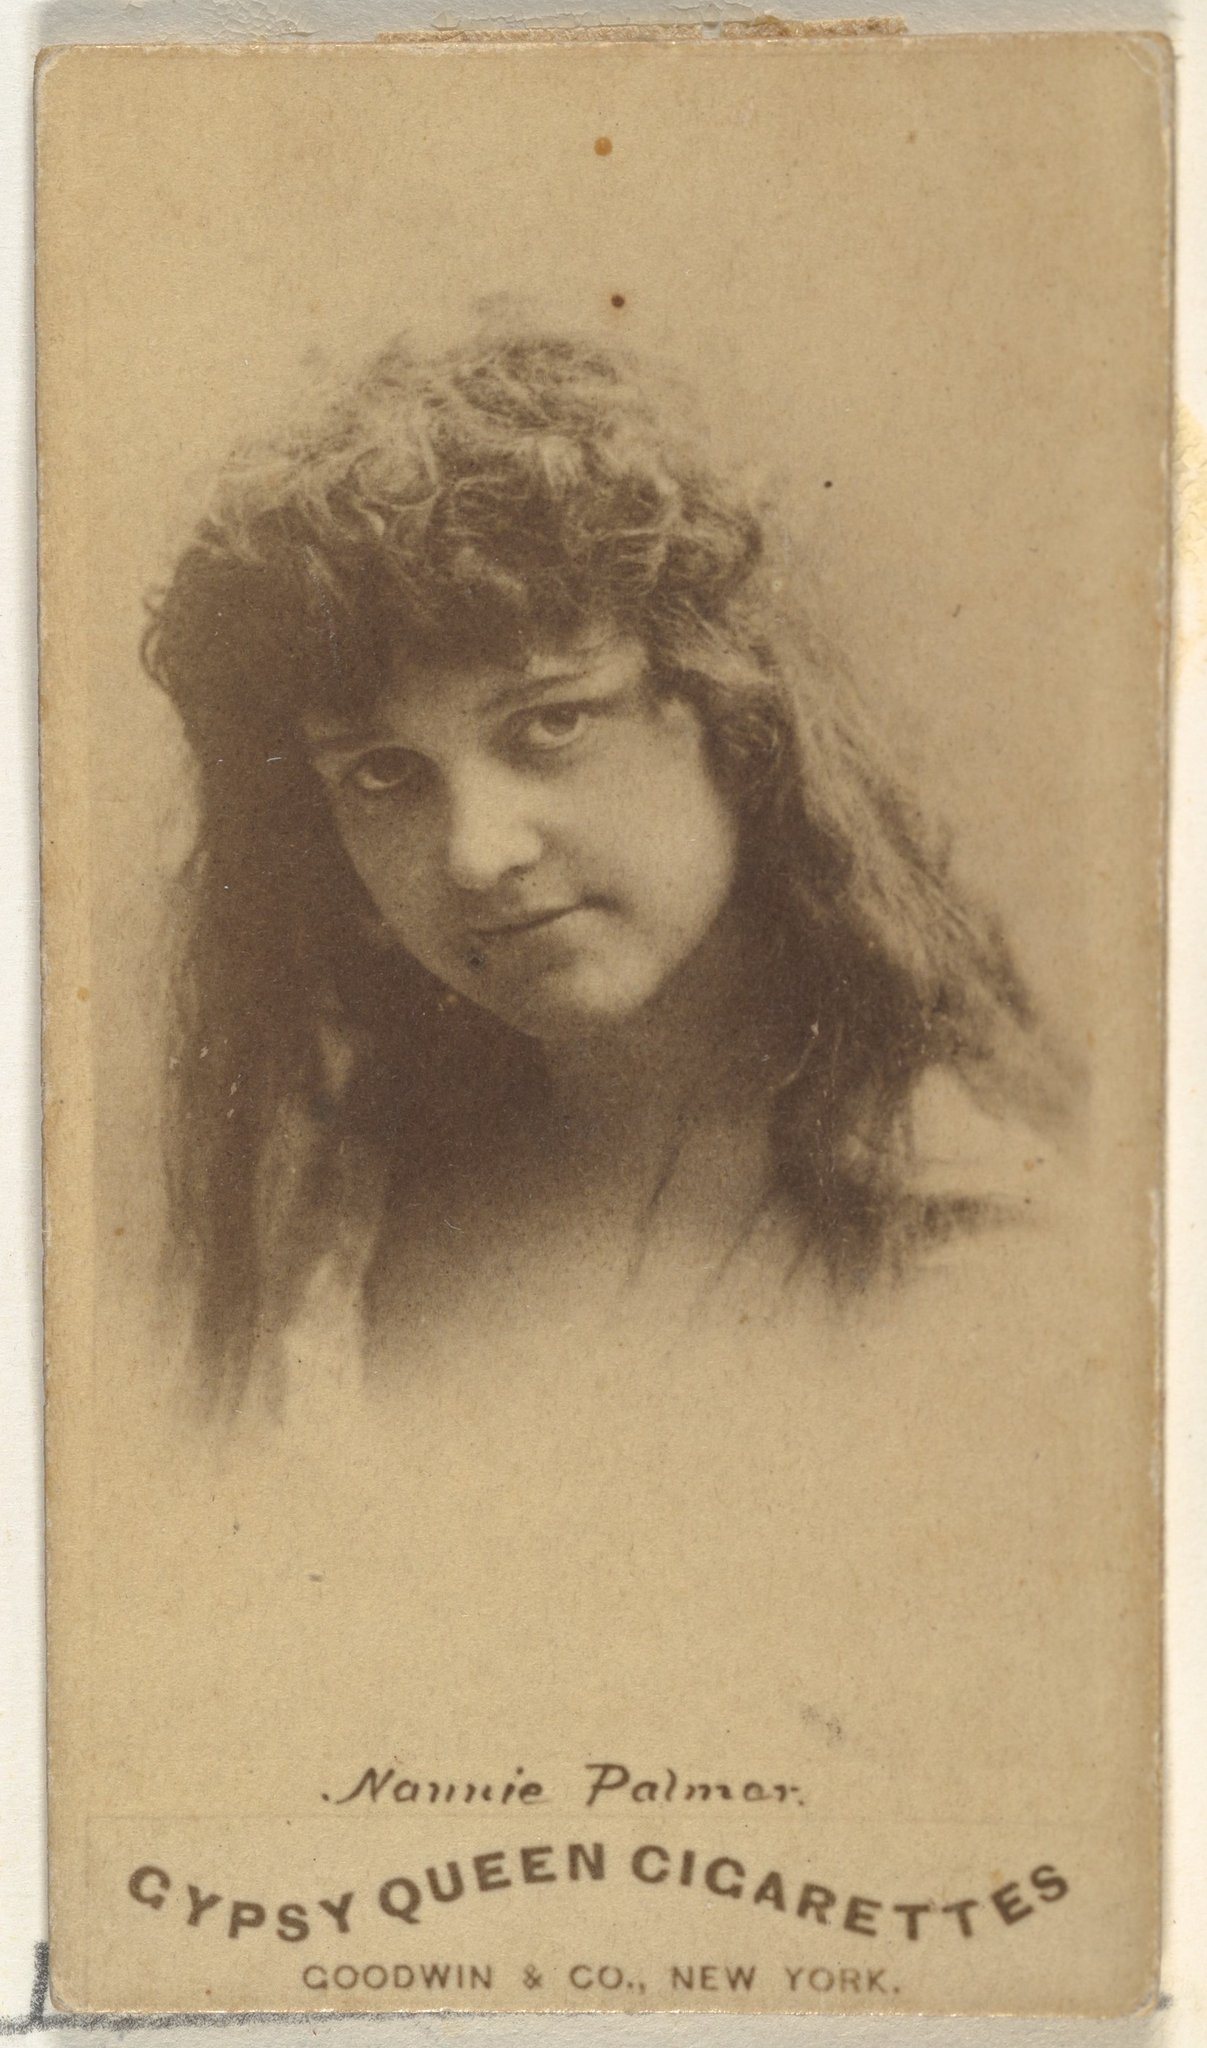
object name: photograph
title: Nonnie Palmer, from the Actors and Actresses series (N171) for Gypsy Queen Cigarettes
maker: goodwin & company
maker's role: publisher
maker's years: 1850-1950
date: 1886-1890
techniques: albumen silver print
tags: portraits,women,actresses